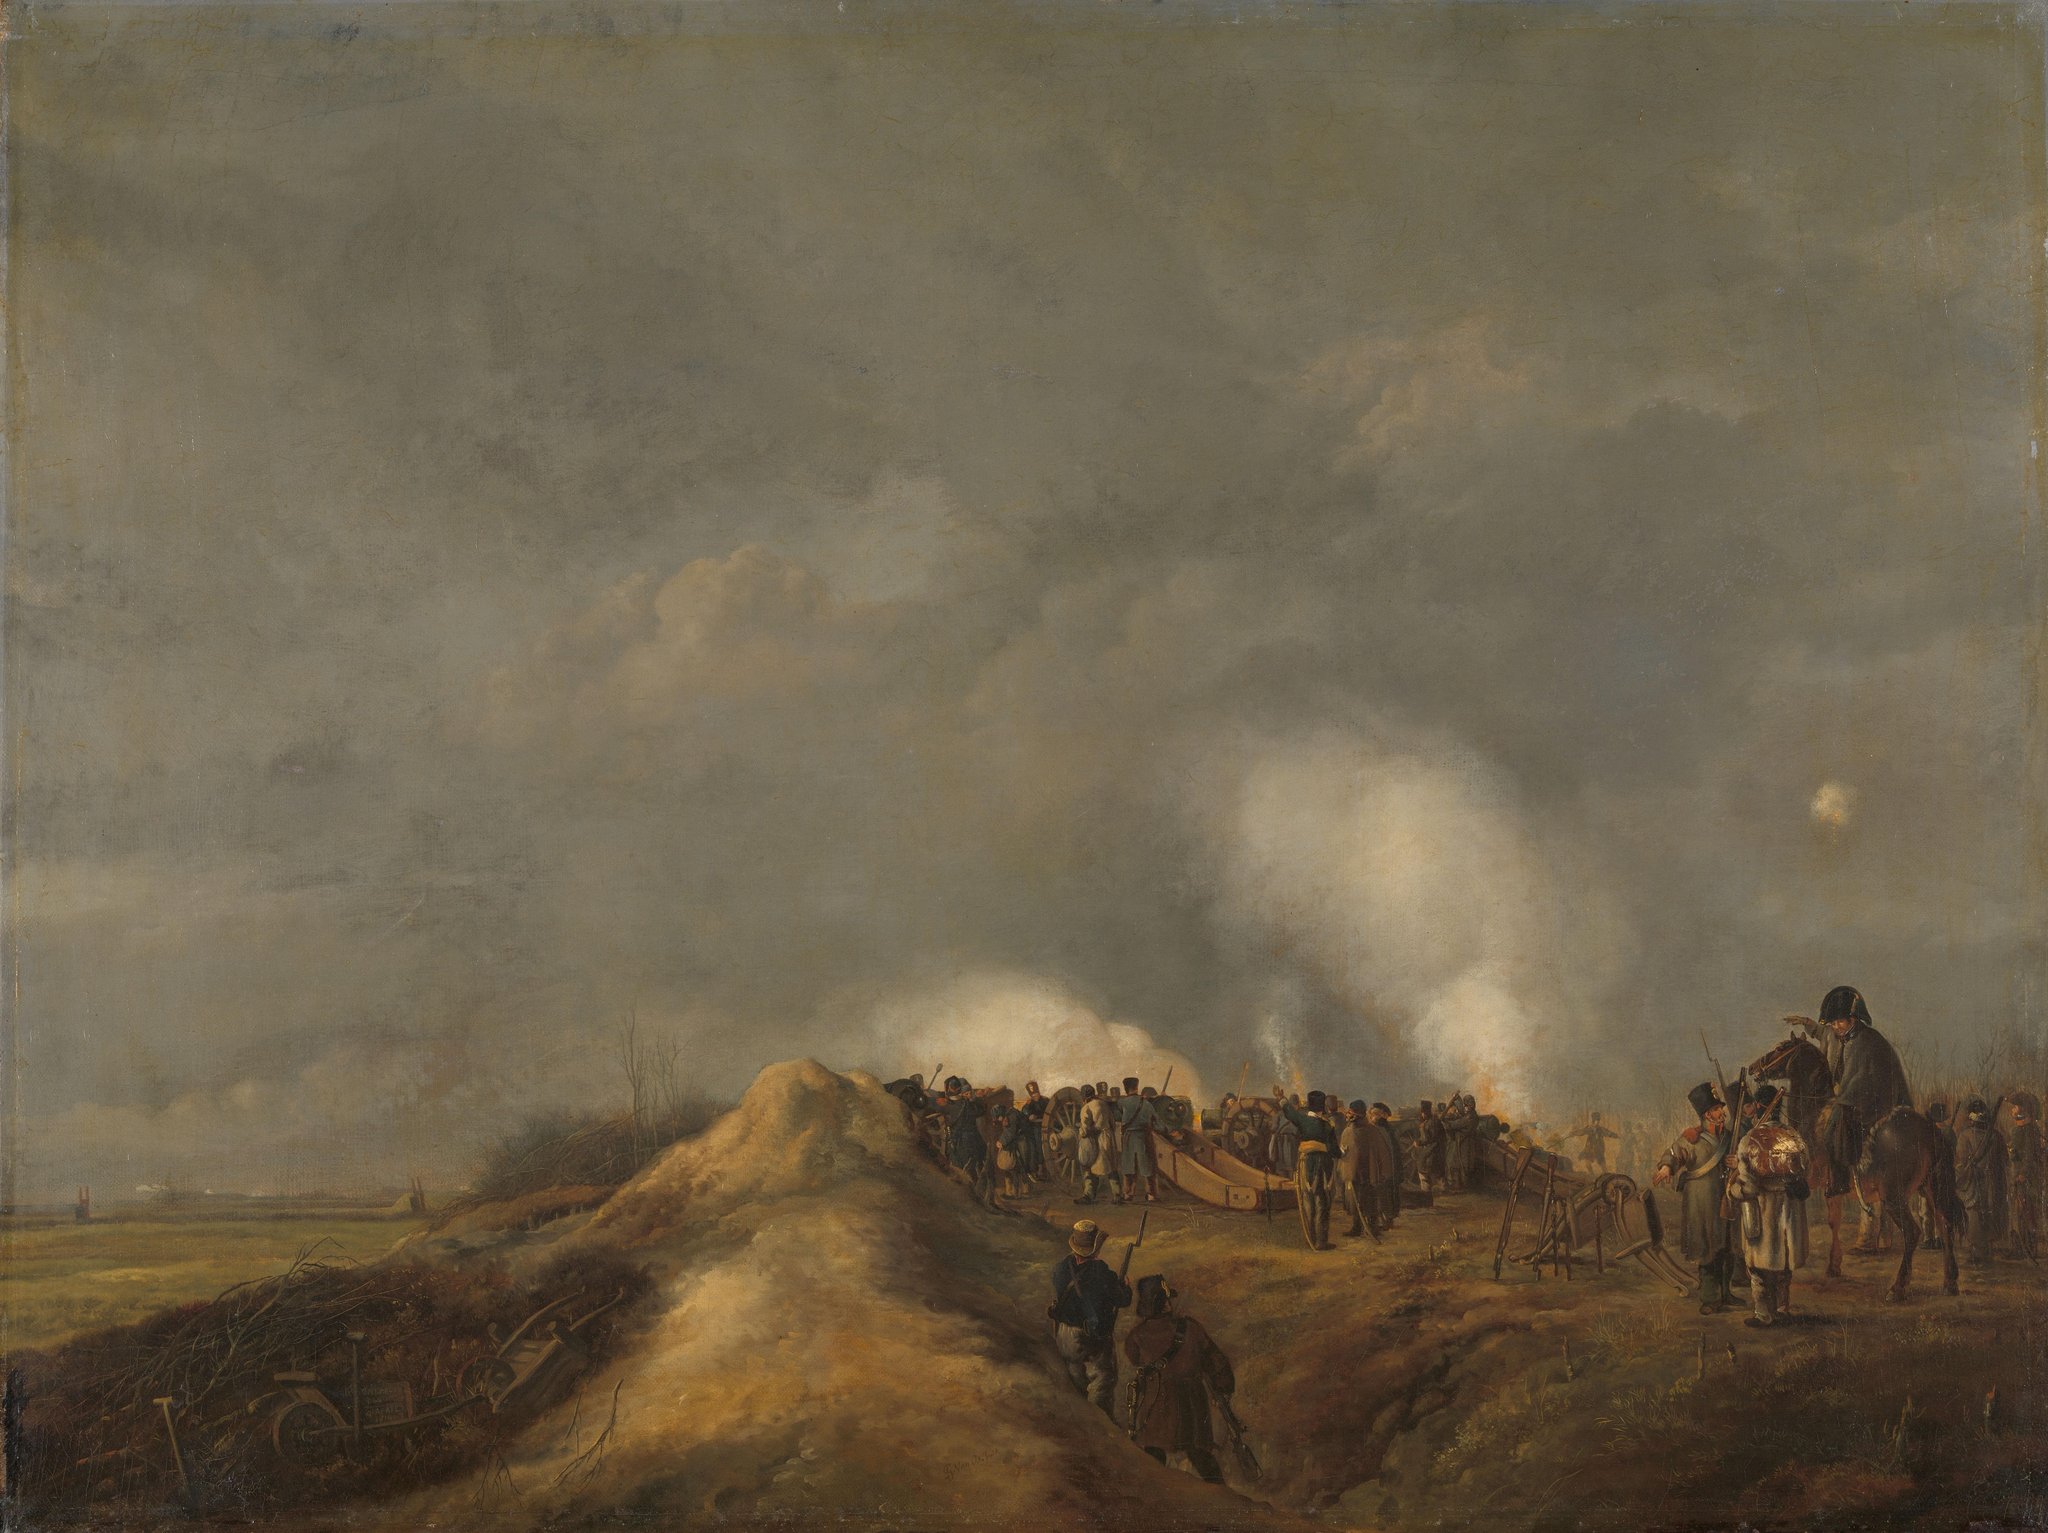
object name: painting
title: The Bombardment of Naarden, April 1814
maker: pieter gerardus van os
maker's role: draughtsman, painter, print maker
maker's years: 1776-1839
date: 1814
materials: canvas, oil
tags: siege, position war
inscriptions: signature: ‘PG van Os’, inscription and date: ‘Kommerrust den 4e April 1814’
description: Het beschieten van Naarden, april 1814. Op een schans bij Kommerrust staan soldaten en officieren bij kanonnen waarmee op de stad Naarden geschoten wordt. Links op de helling liggen enkele kruiwagens.